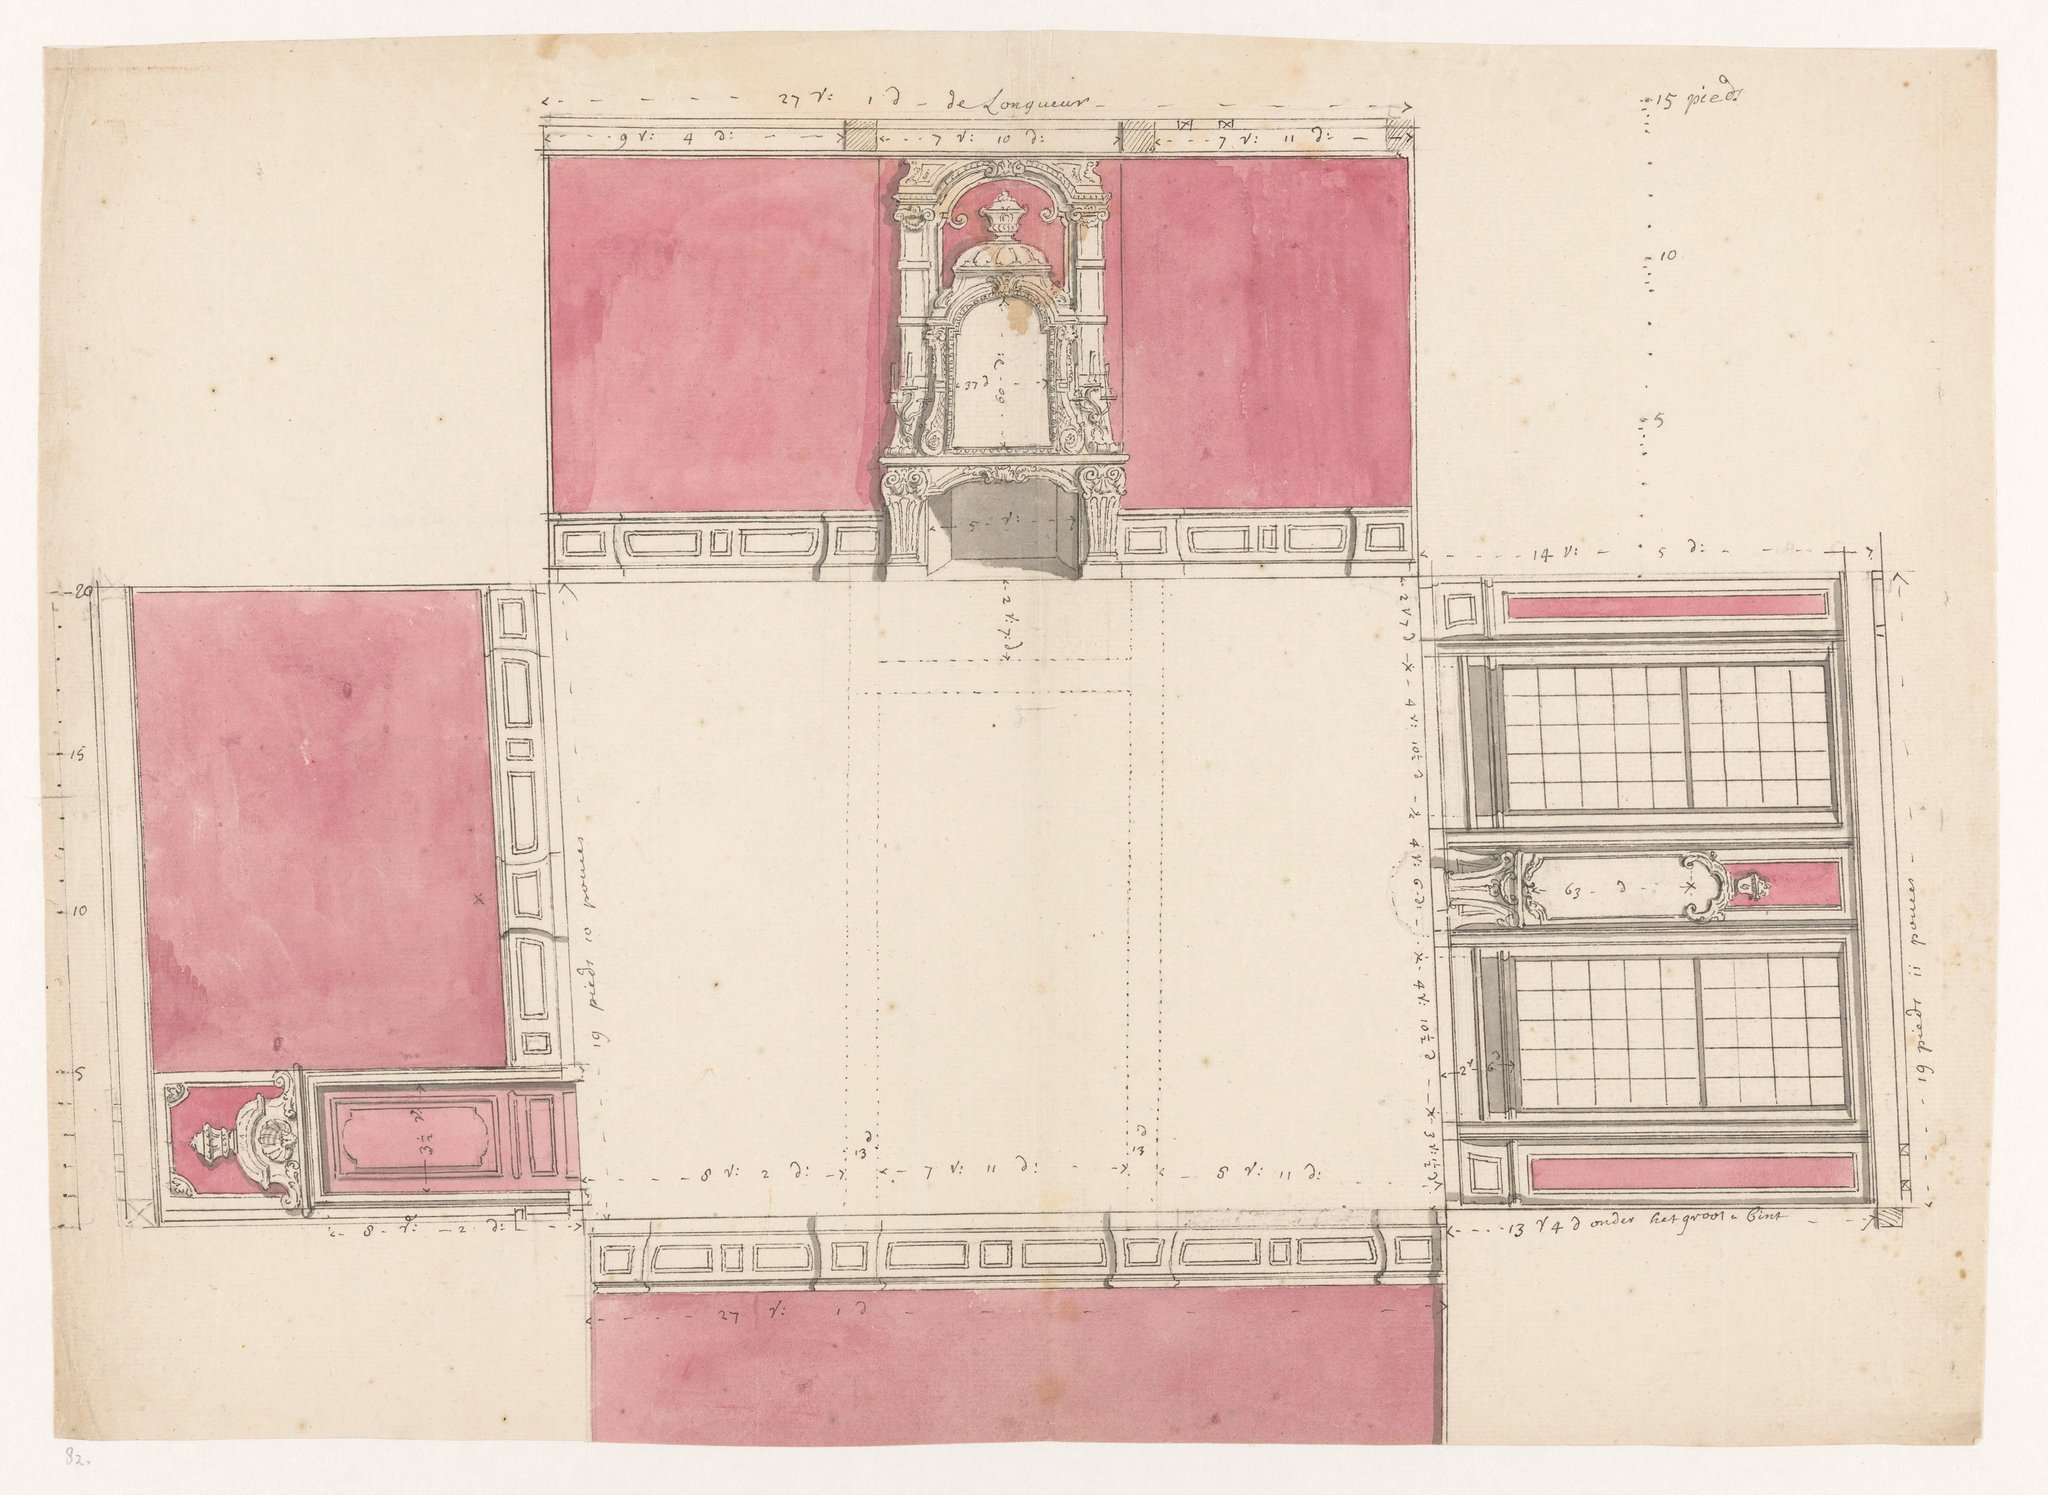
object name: drawing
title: Architectuurstudie van de wanden van een kamer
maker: jan brandes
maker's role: draughtsman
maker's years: 1743-1808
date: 1770-1808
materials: ink, paper, pencil, watercolor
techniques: brush, pen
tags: wall-covering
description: Architectuurstudie van de vier wanden van een rijkversierd vertrek. De wanden liggen als het ware uitgeklapt om het vloeroppervlak. In de wanden bevinden zich een gebeeldhouwde schouw, de deur en twee ramen. Met afmetingen.